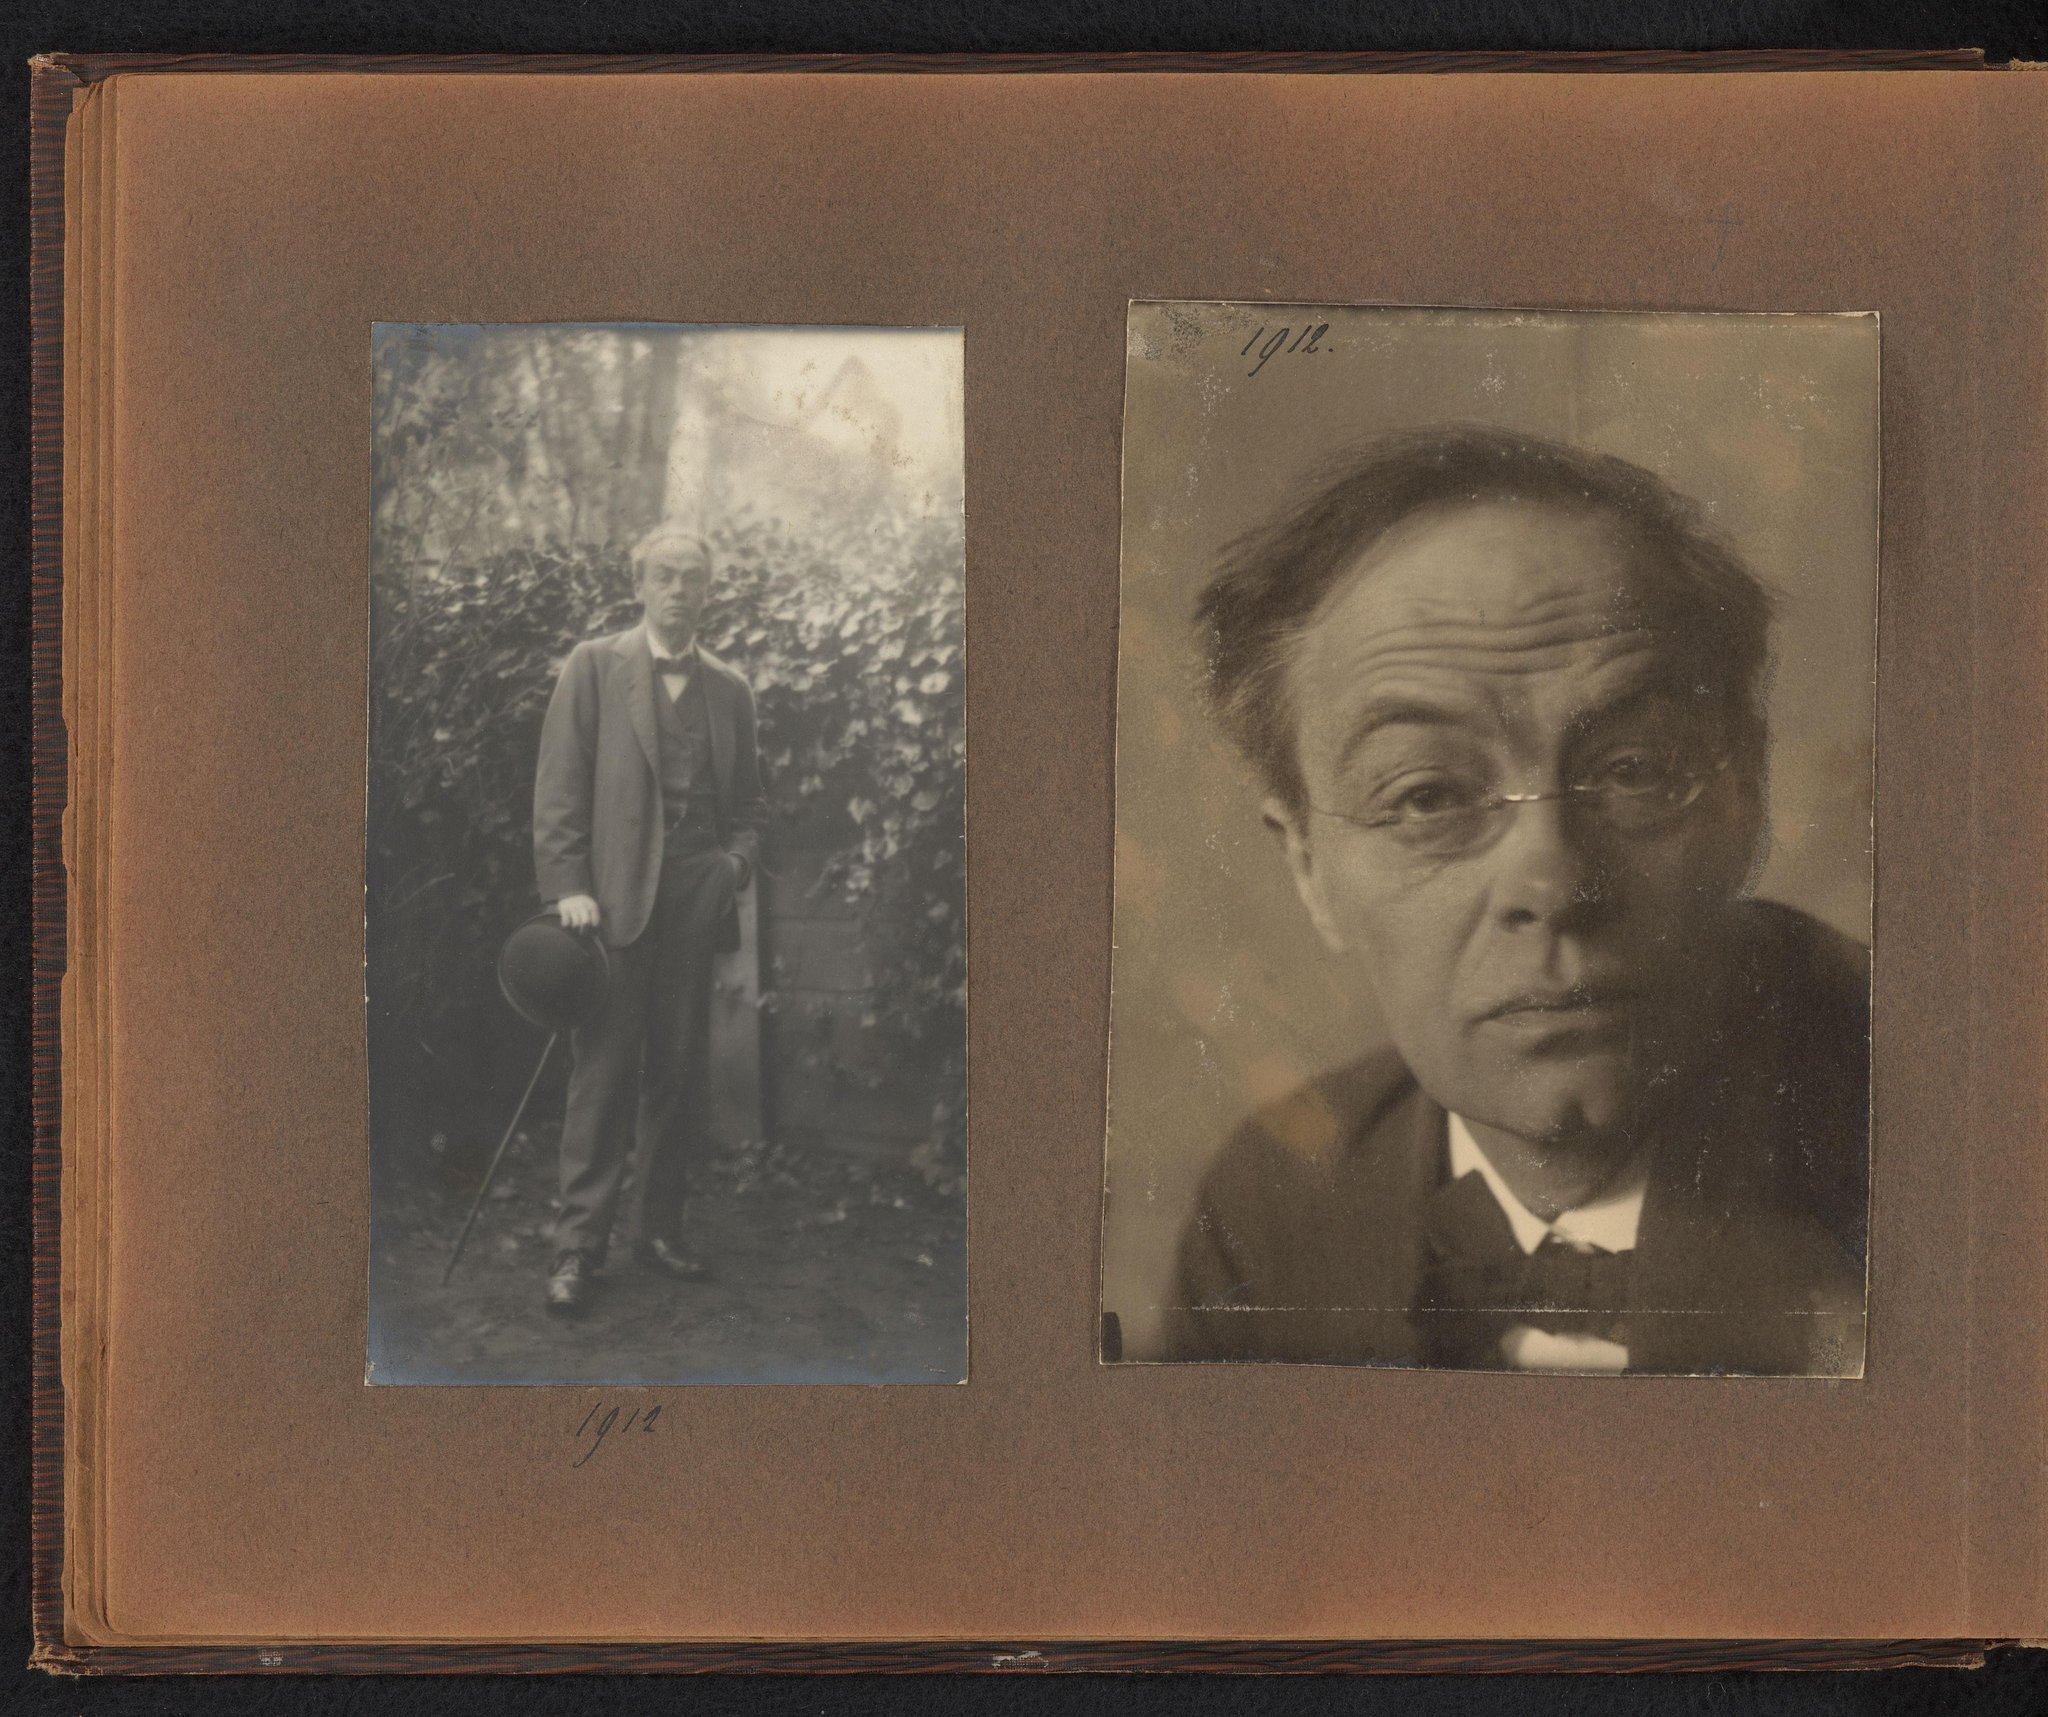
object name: photograph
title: Bladzijde uit het fotoalbum van de familie Diepenbrock met 2 foto's van Alphons Diepenbrock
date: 1912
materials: cardboard, photographic support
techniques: photography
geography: netherlands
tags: alphons diepenbrock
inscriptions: date: ‘1912 1912.’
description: Bruin albumblad 8 van familiealbum van Alphons Diepenbrock.